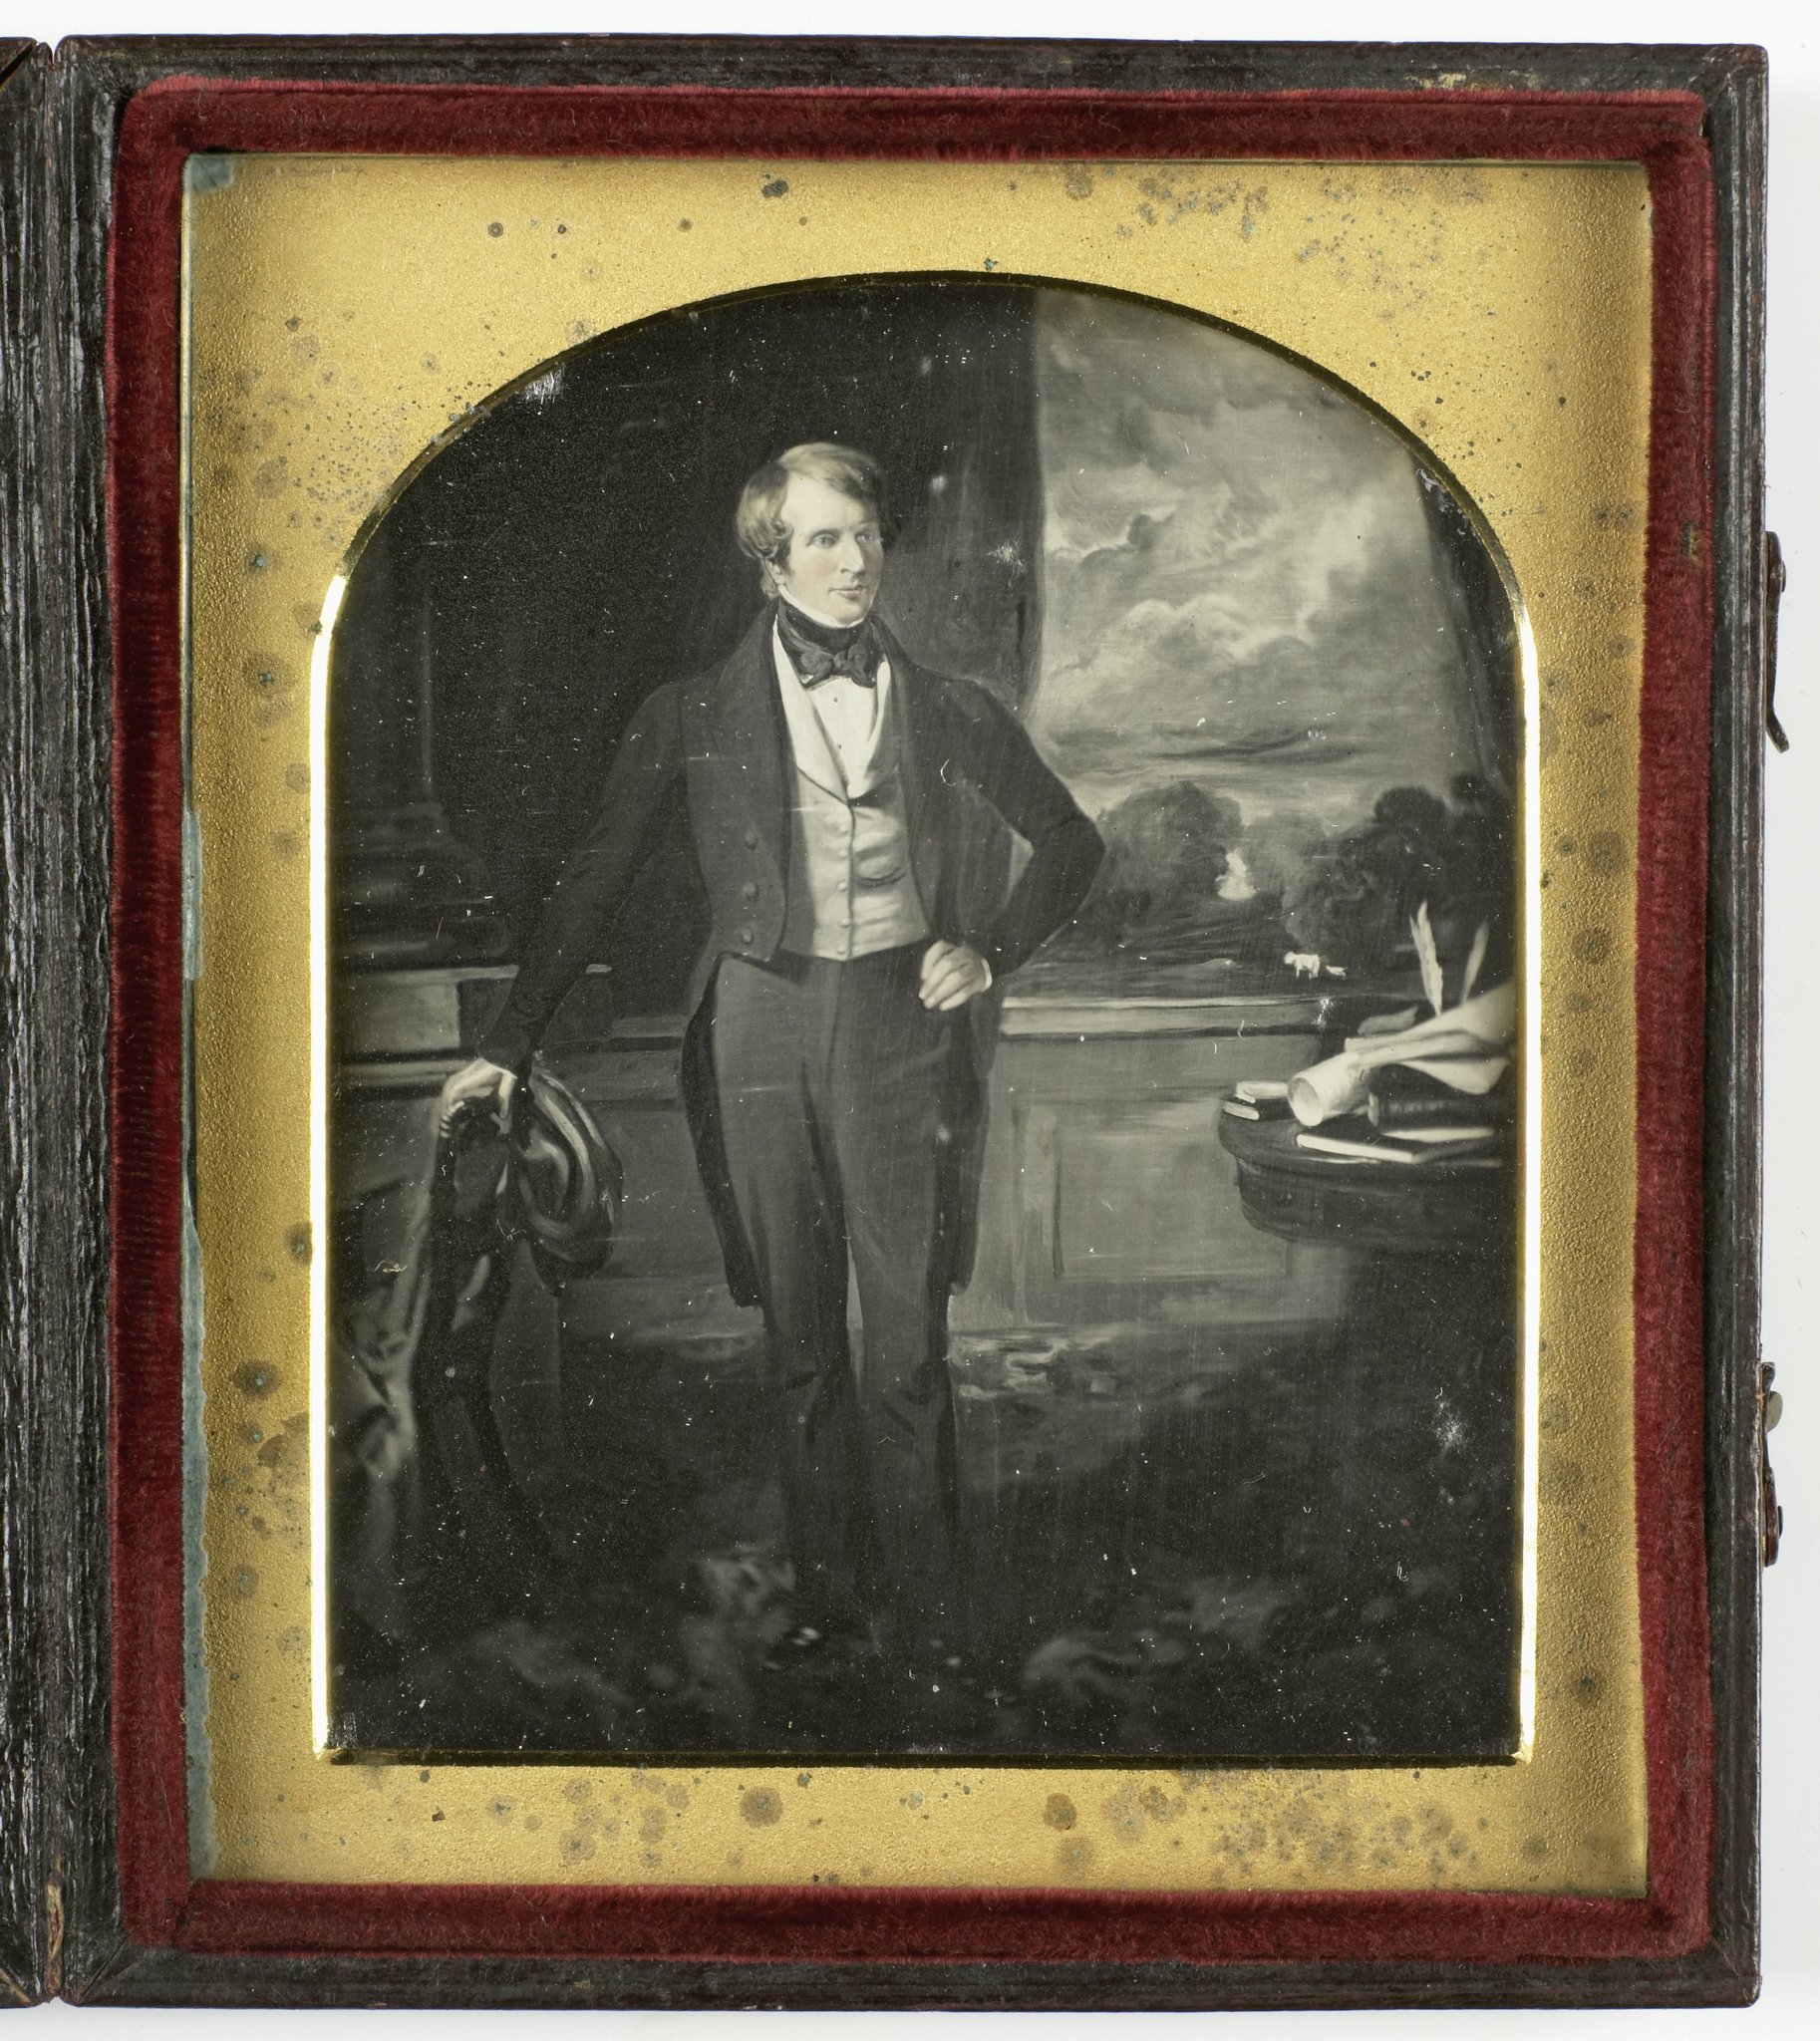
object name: reproduction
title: Fotoreproductie van een geschilderd portret van een onbekende man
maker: Anonymous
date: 1840-1860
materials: copper, glass, leather, velvet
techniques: daguerreotype, hand coloring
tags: adult man, painting, drawing and the graphic arts